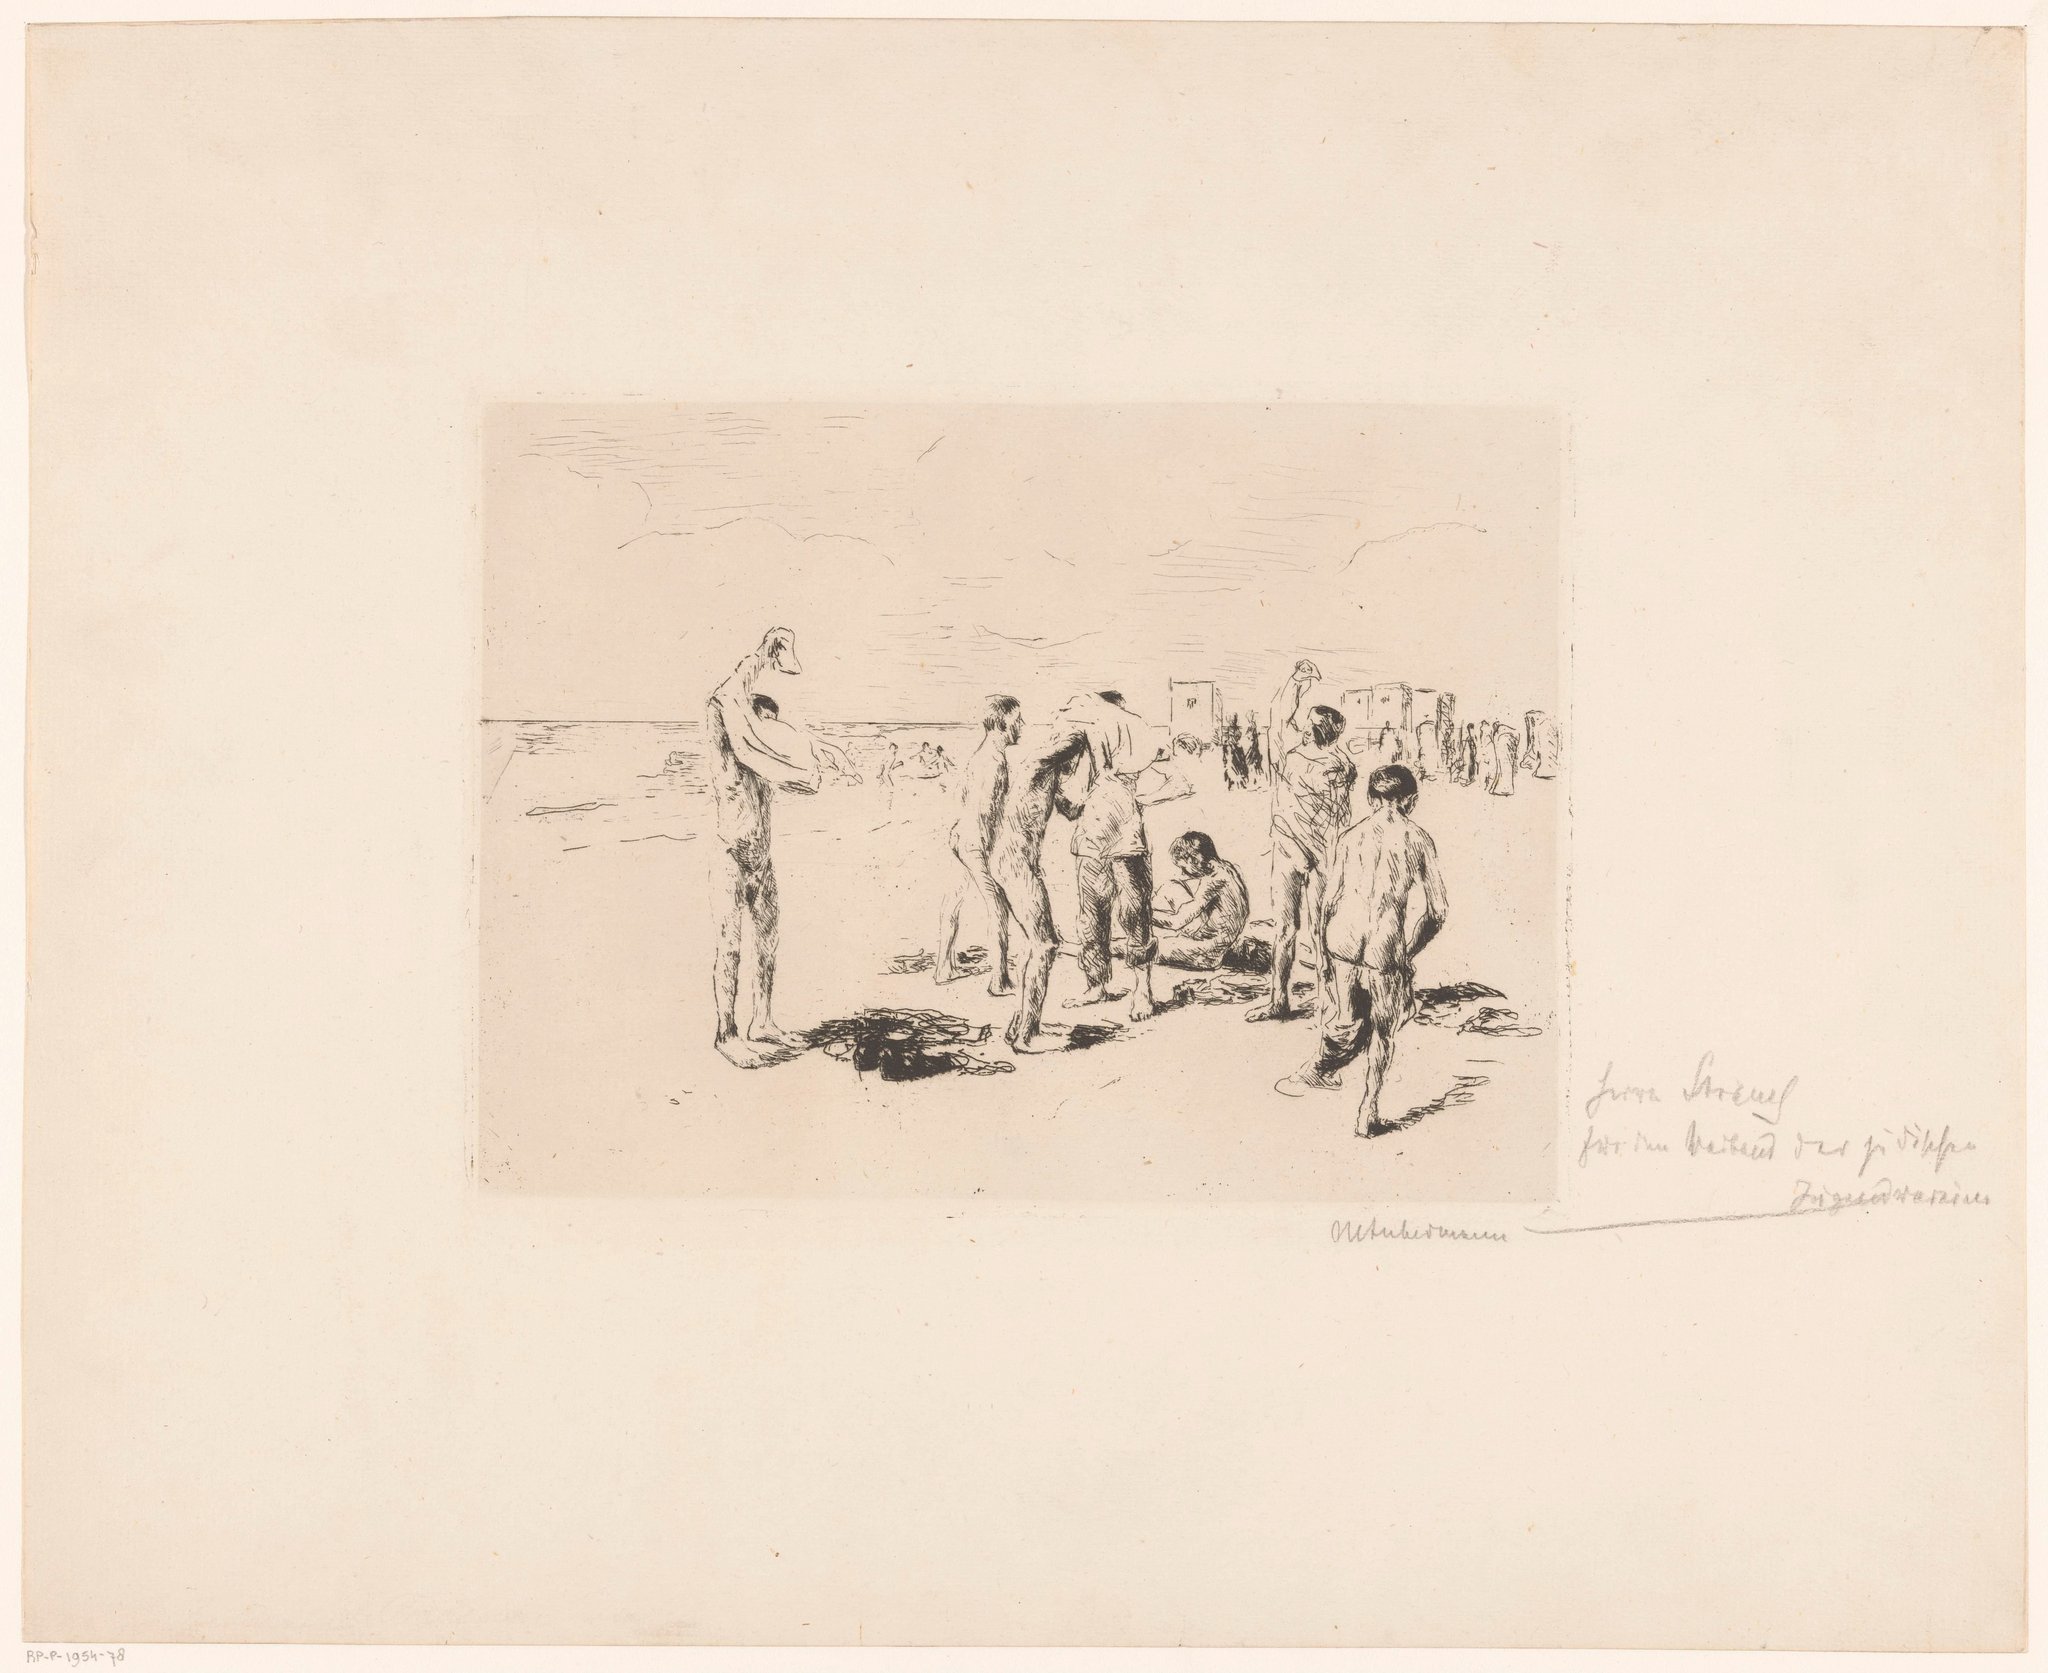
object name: print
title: Badende jongens bij het strand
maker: max liebermann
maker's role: draughtsman, print maker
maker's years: 1847-1935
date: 1857-1935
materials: paper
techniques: etching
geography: berlin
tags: taking a bath - aa - in the open air, beach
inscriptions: collector's mark: Lugt 2760, collector's mark: Lugt 2228